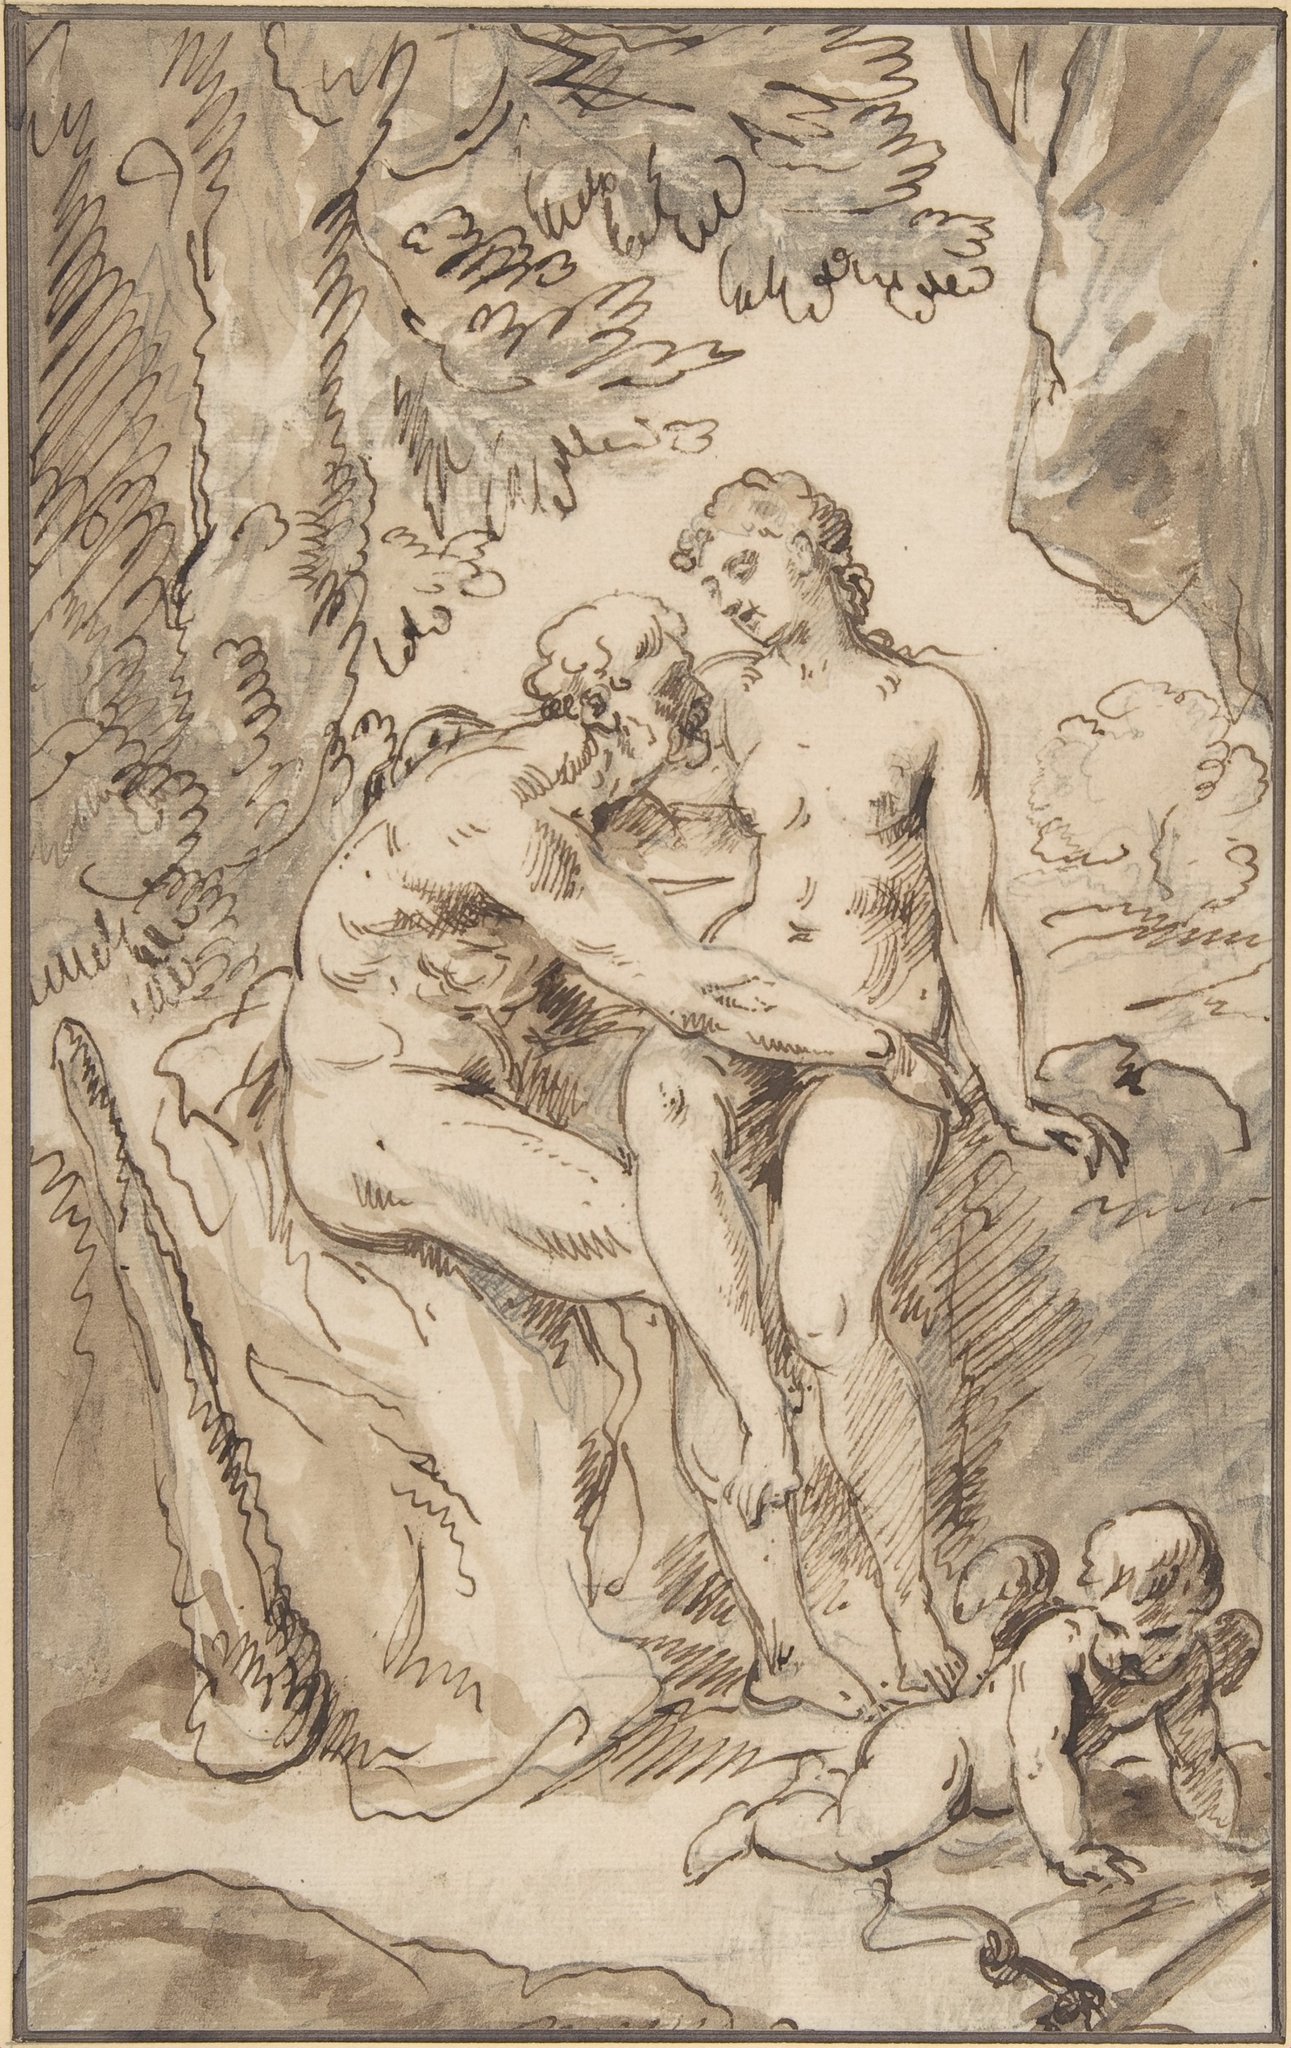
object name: drawing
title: Venus, Mars, and Cupid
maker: anonymous, french, 18th century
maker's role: artist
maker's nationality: french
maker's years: 1700-1800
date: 1701-1800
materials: graphite, ink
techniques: brush, pen, wash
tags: cupid,mars,venus